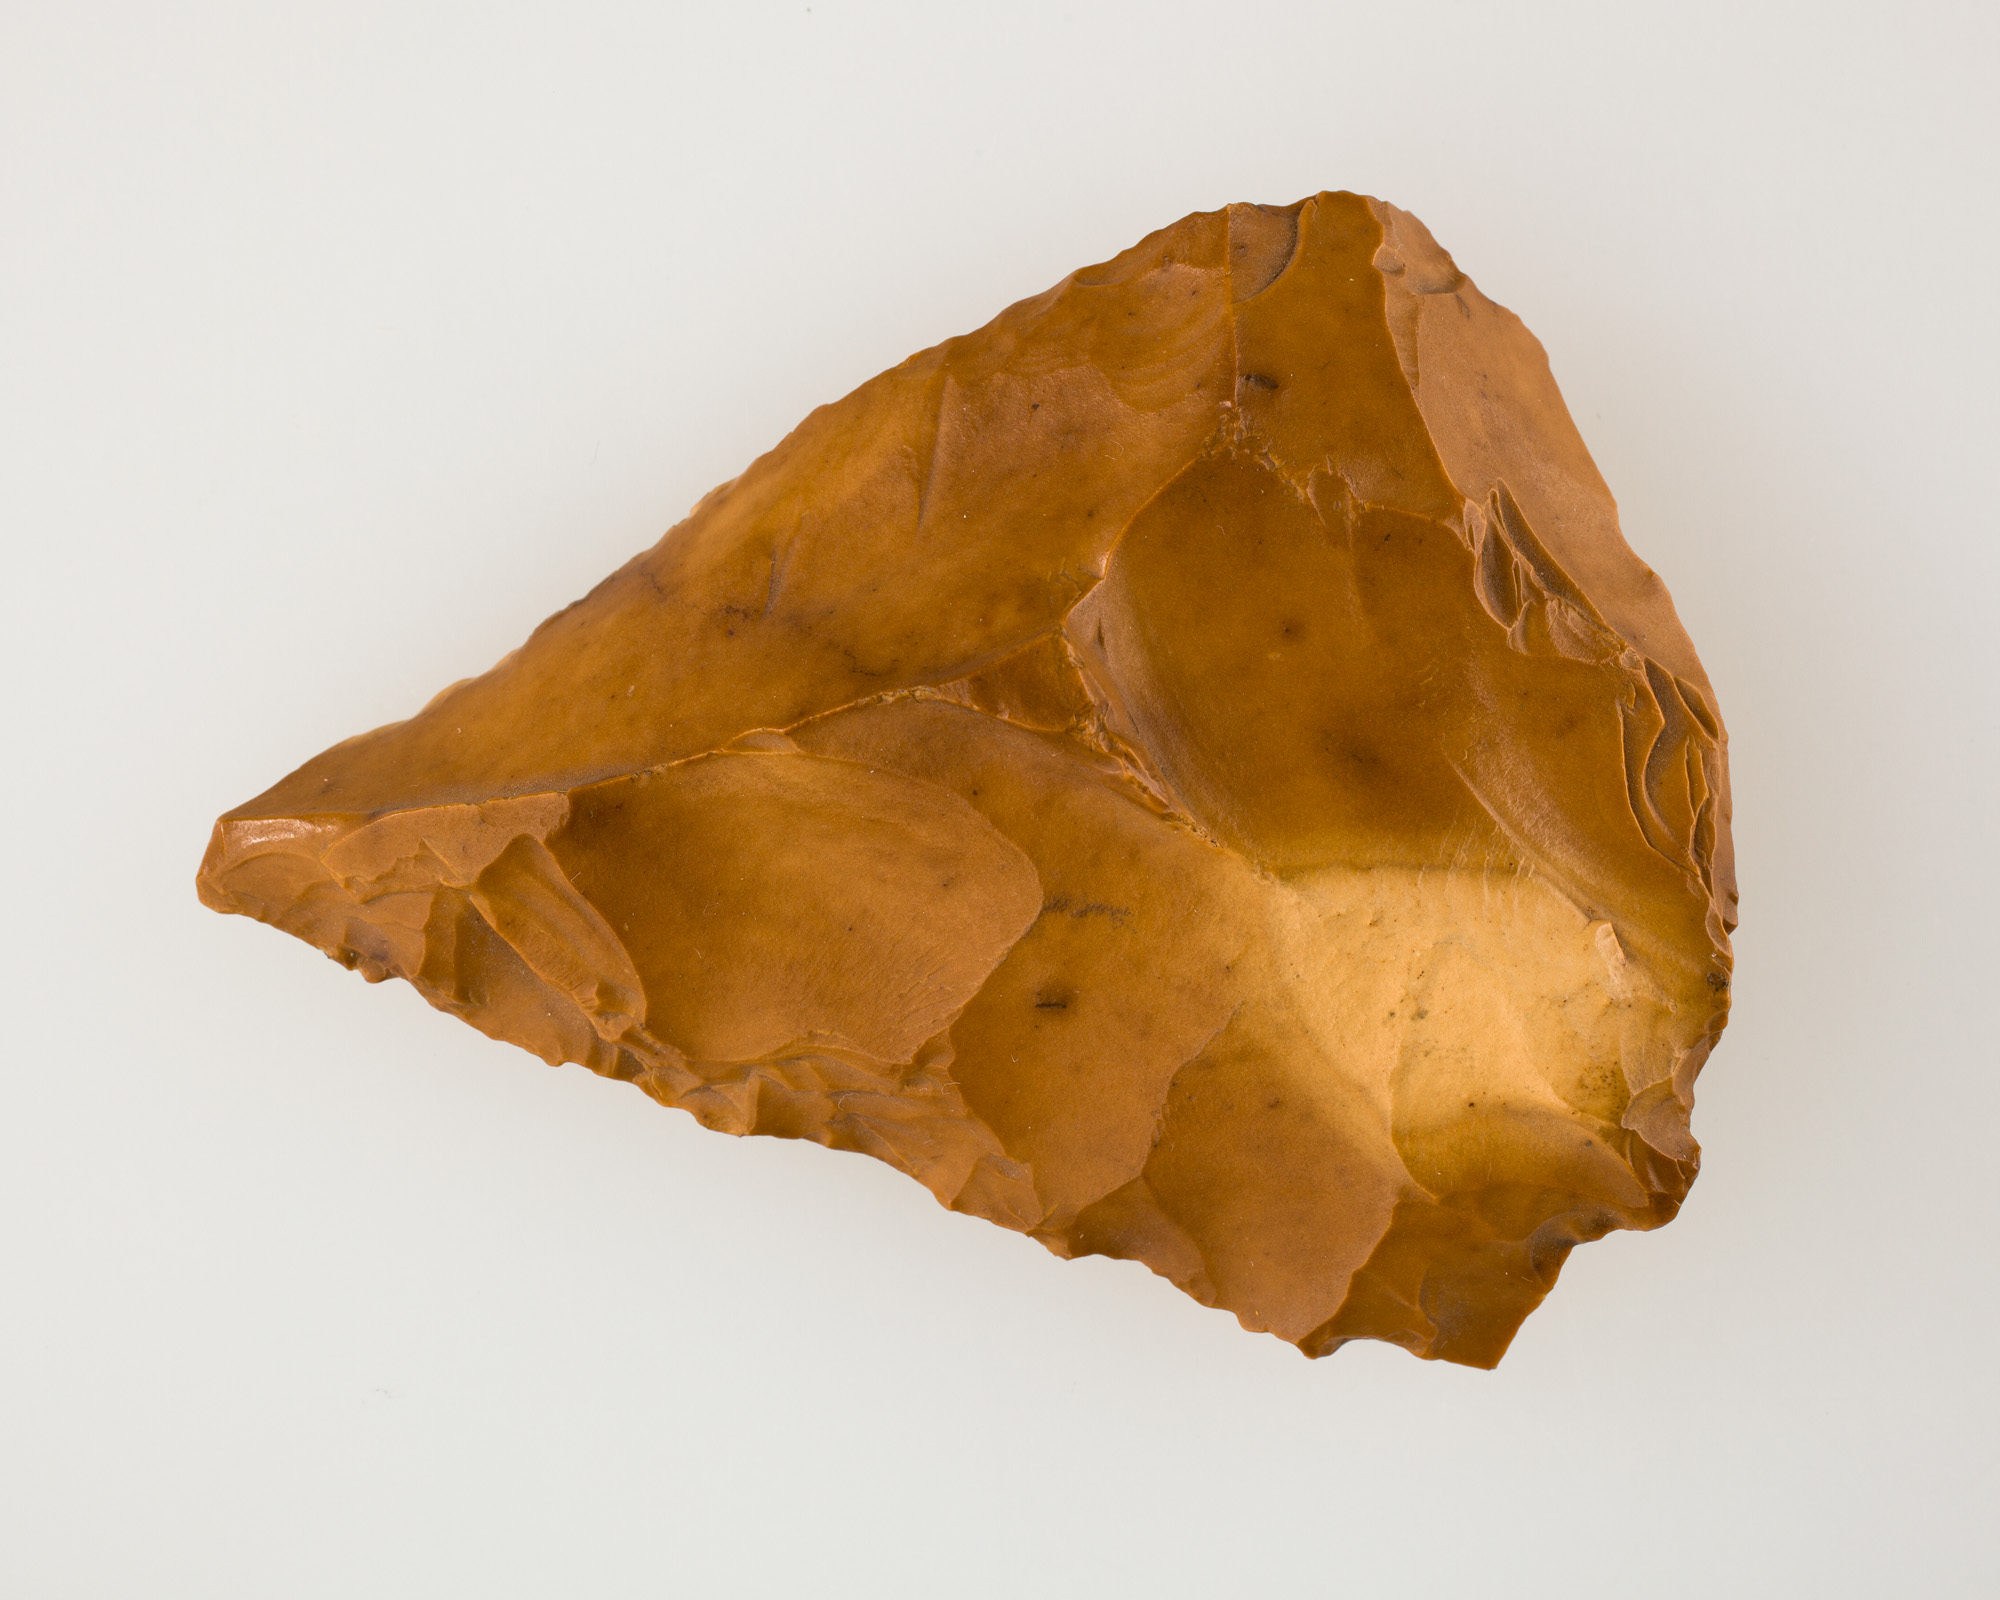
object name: tool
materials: stone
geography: egypt